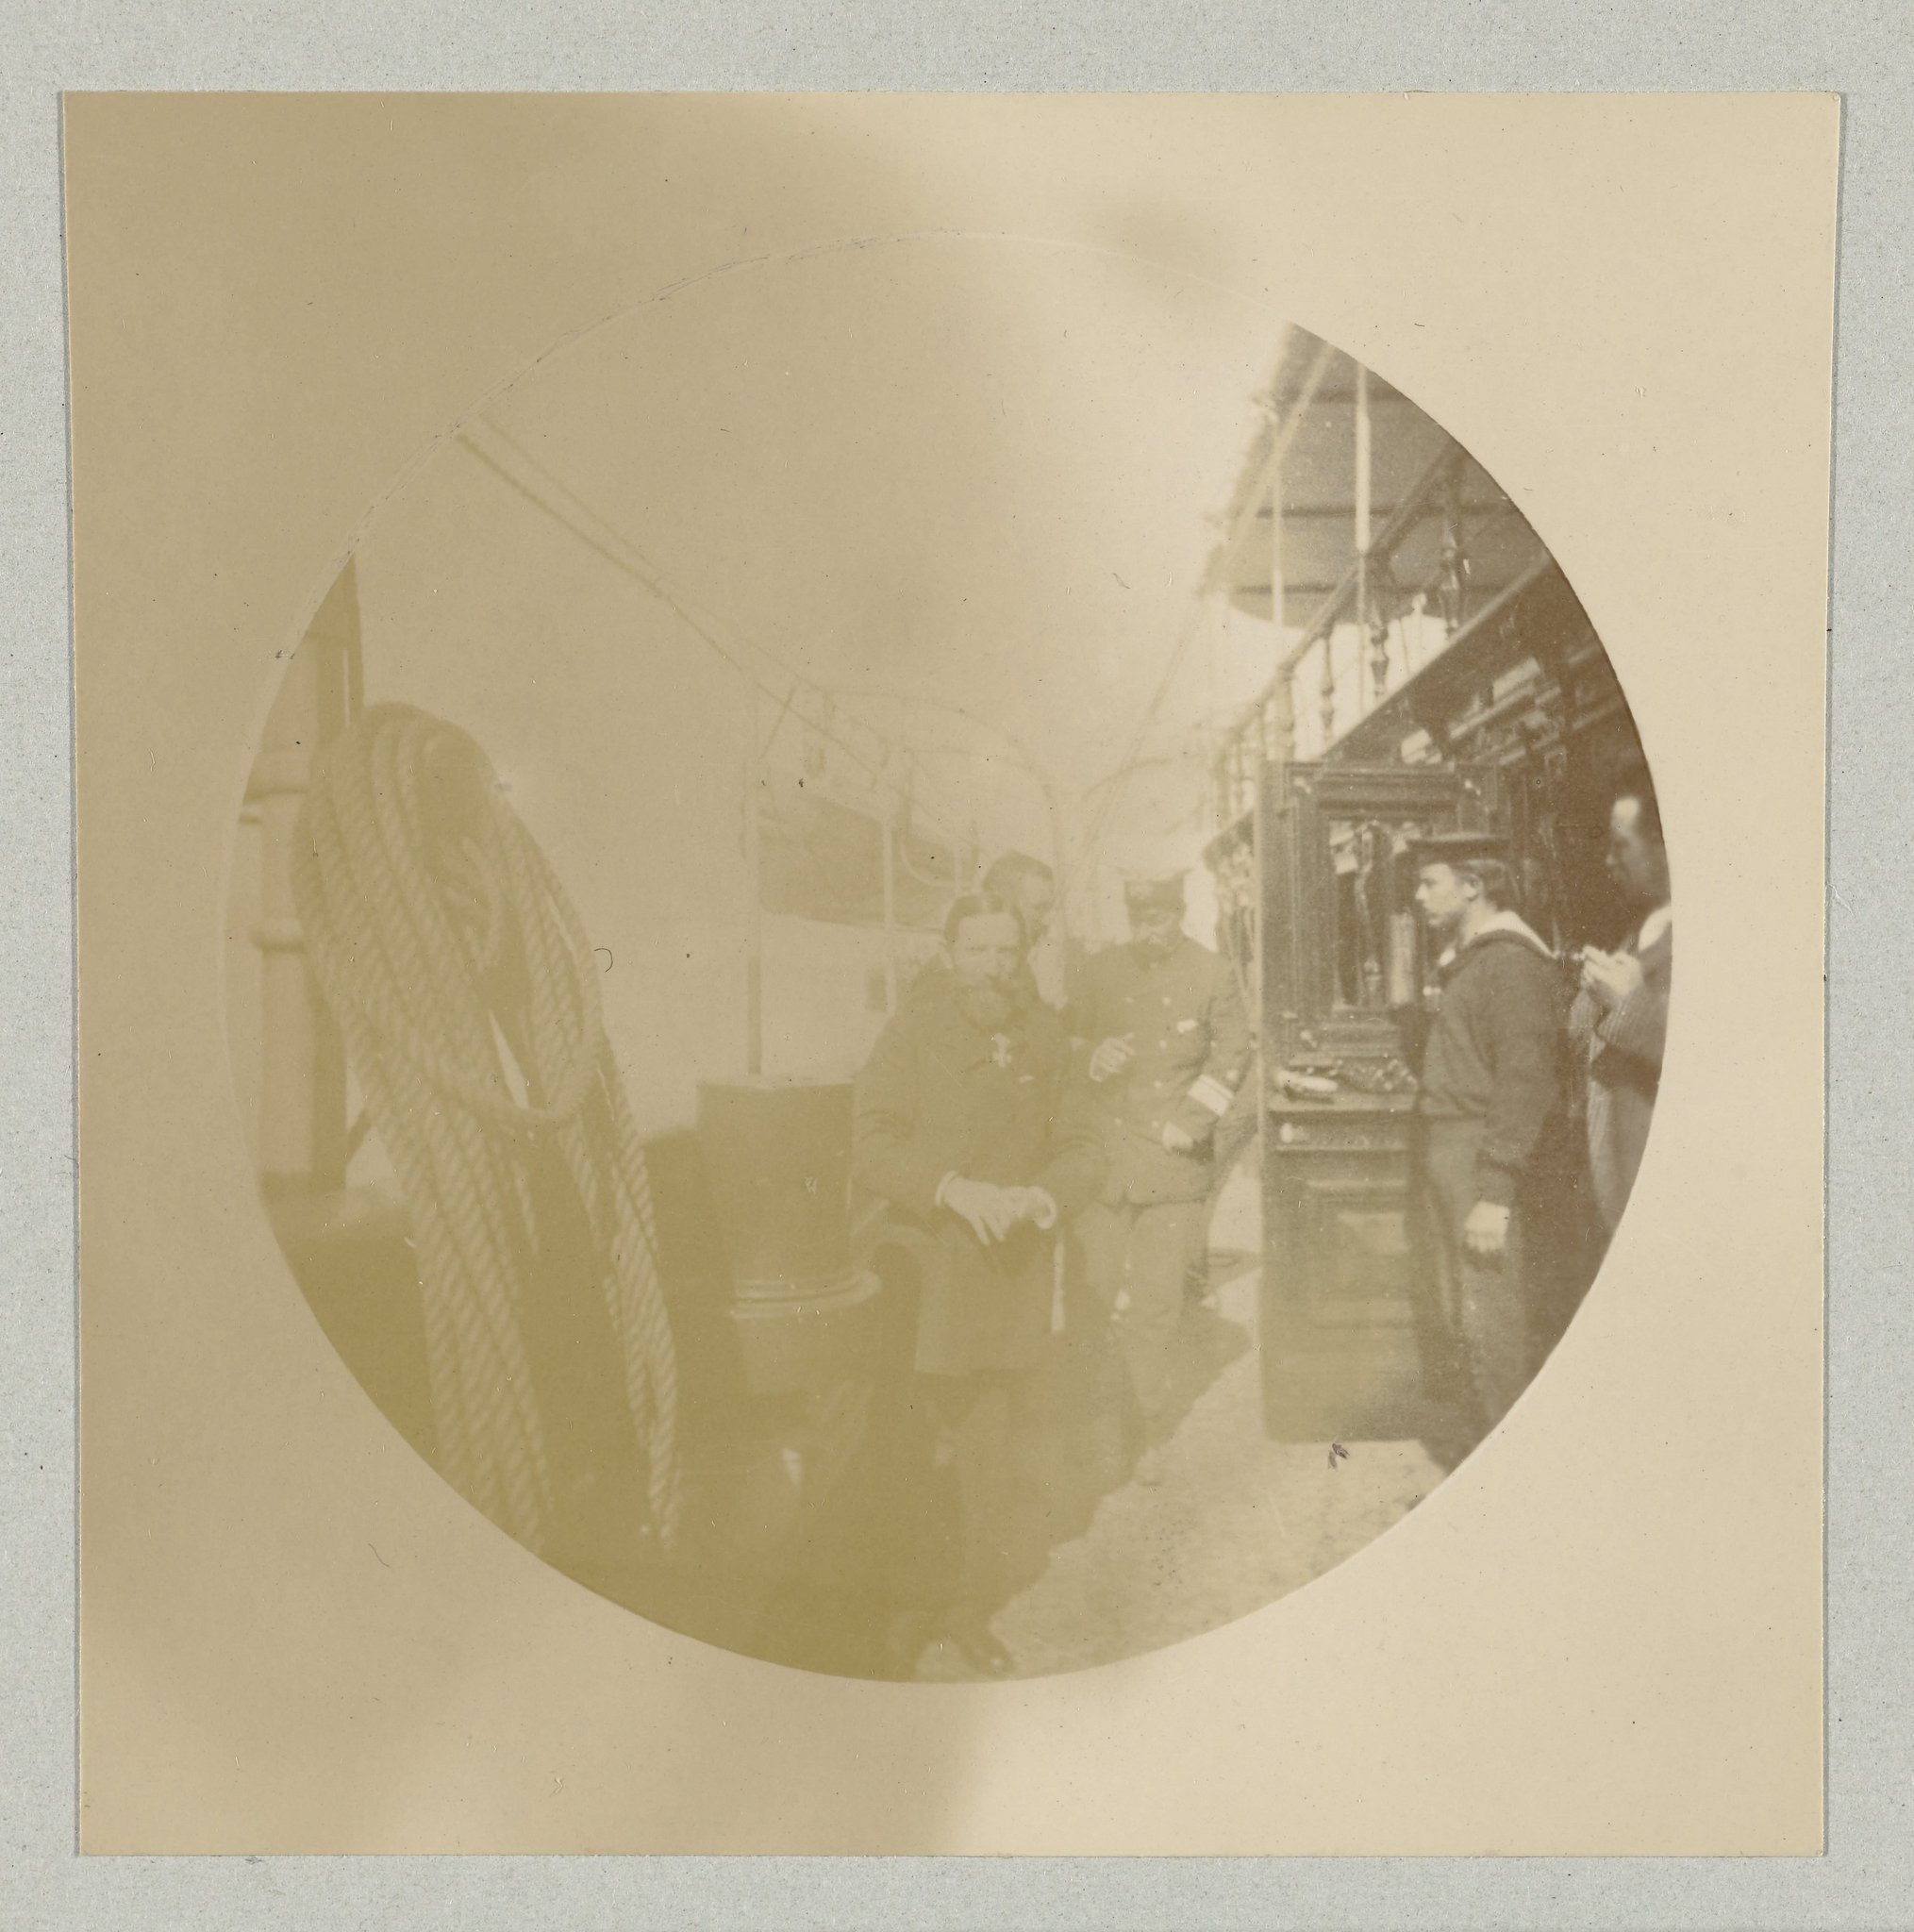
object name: photograph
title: Errinnerungen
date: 1807-1889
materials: cardboard, paper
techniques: gelatin silver print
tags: wilhelm ii (keizer van duitsland), norway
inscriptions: number: ‘21’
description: De afdruk van de foto is rond, het papier vierkant. foto gemaakt met Nr. 1 Kodak Camera